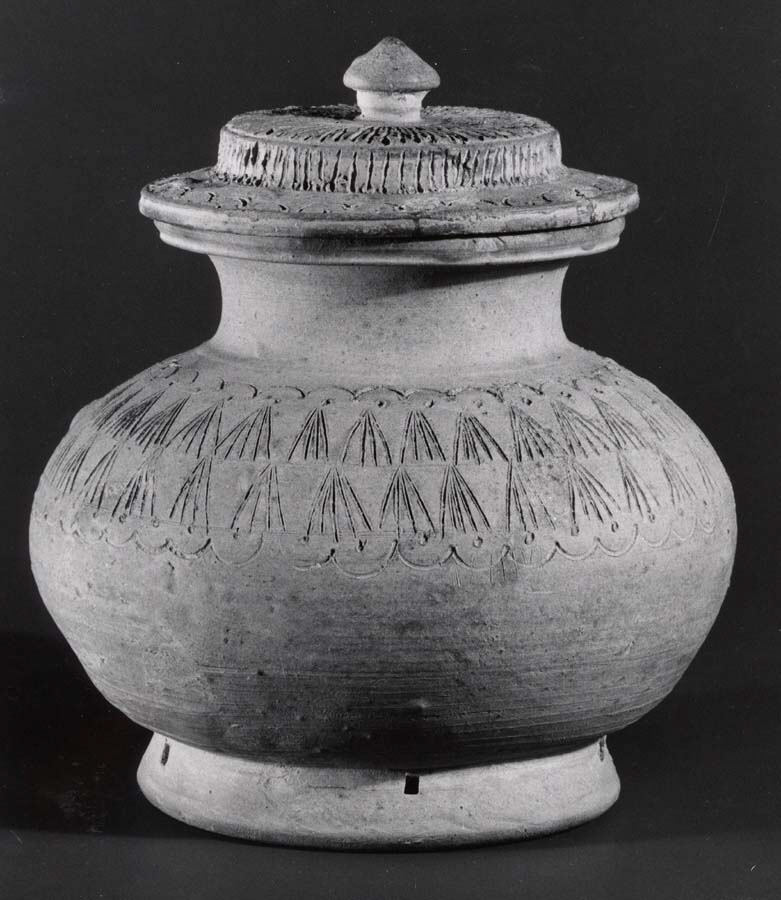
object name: vessel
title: Vessel with Cover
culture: korean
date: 601-700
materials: earthenware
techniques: incising